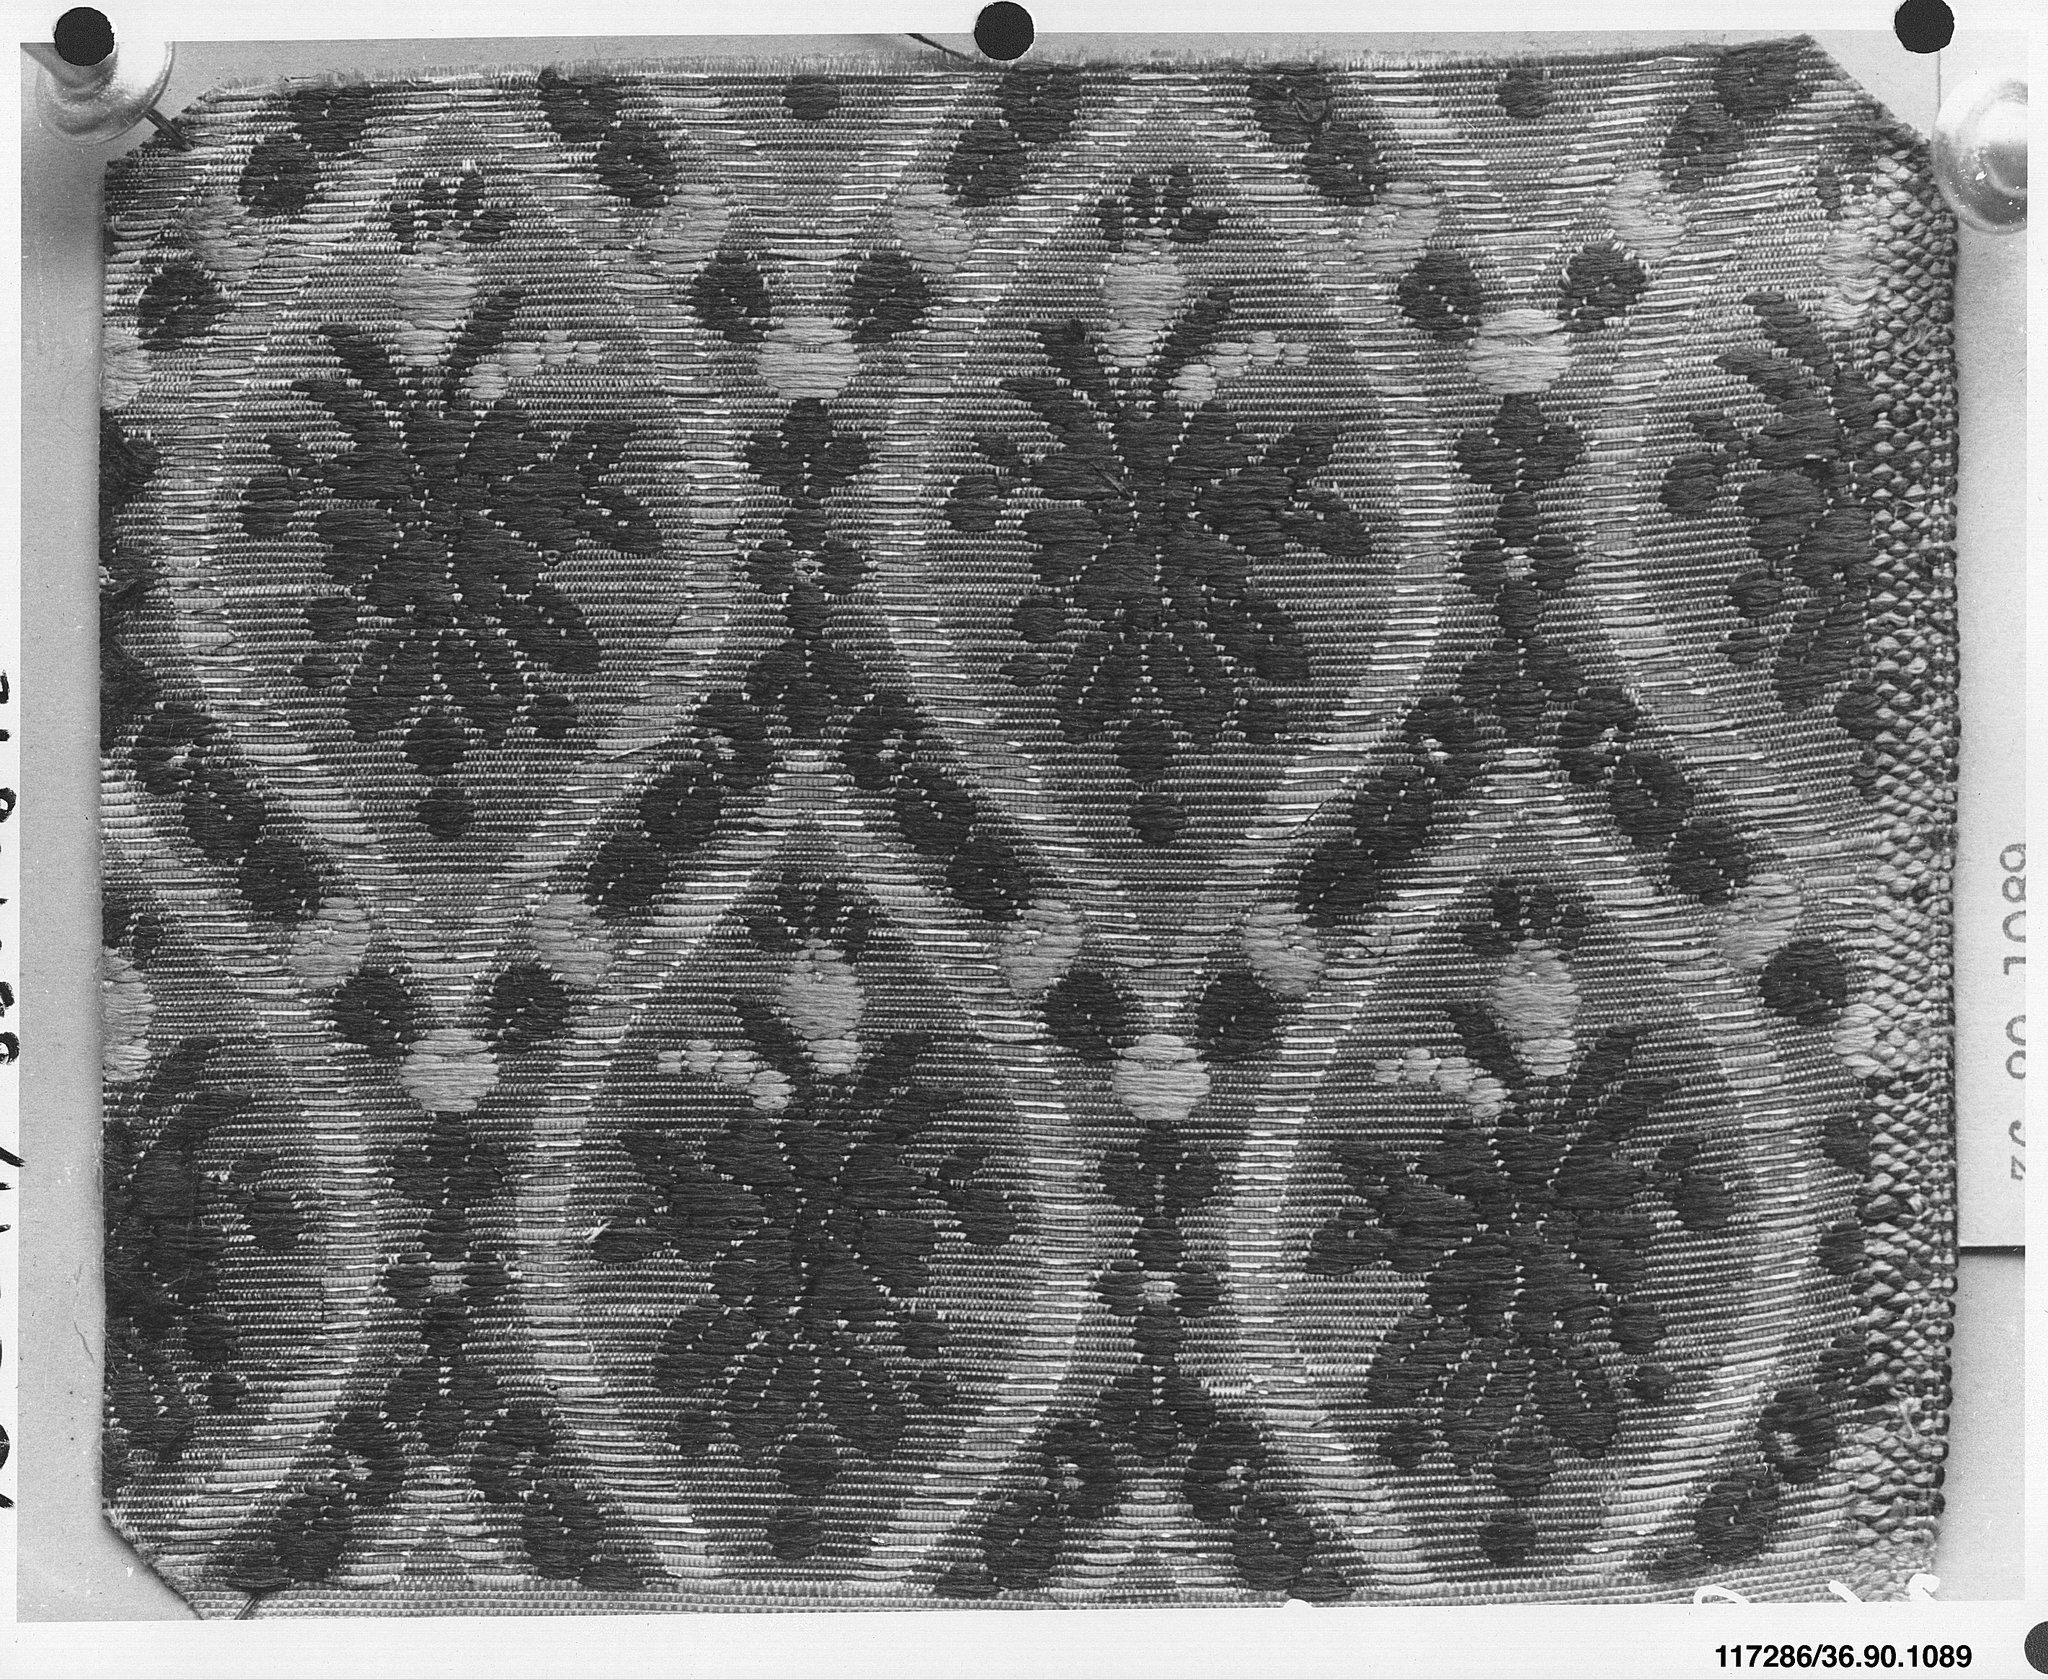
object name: piece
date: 1701-1900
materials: metal thread, silk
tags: leaves